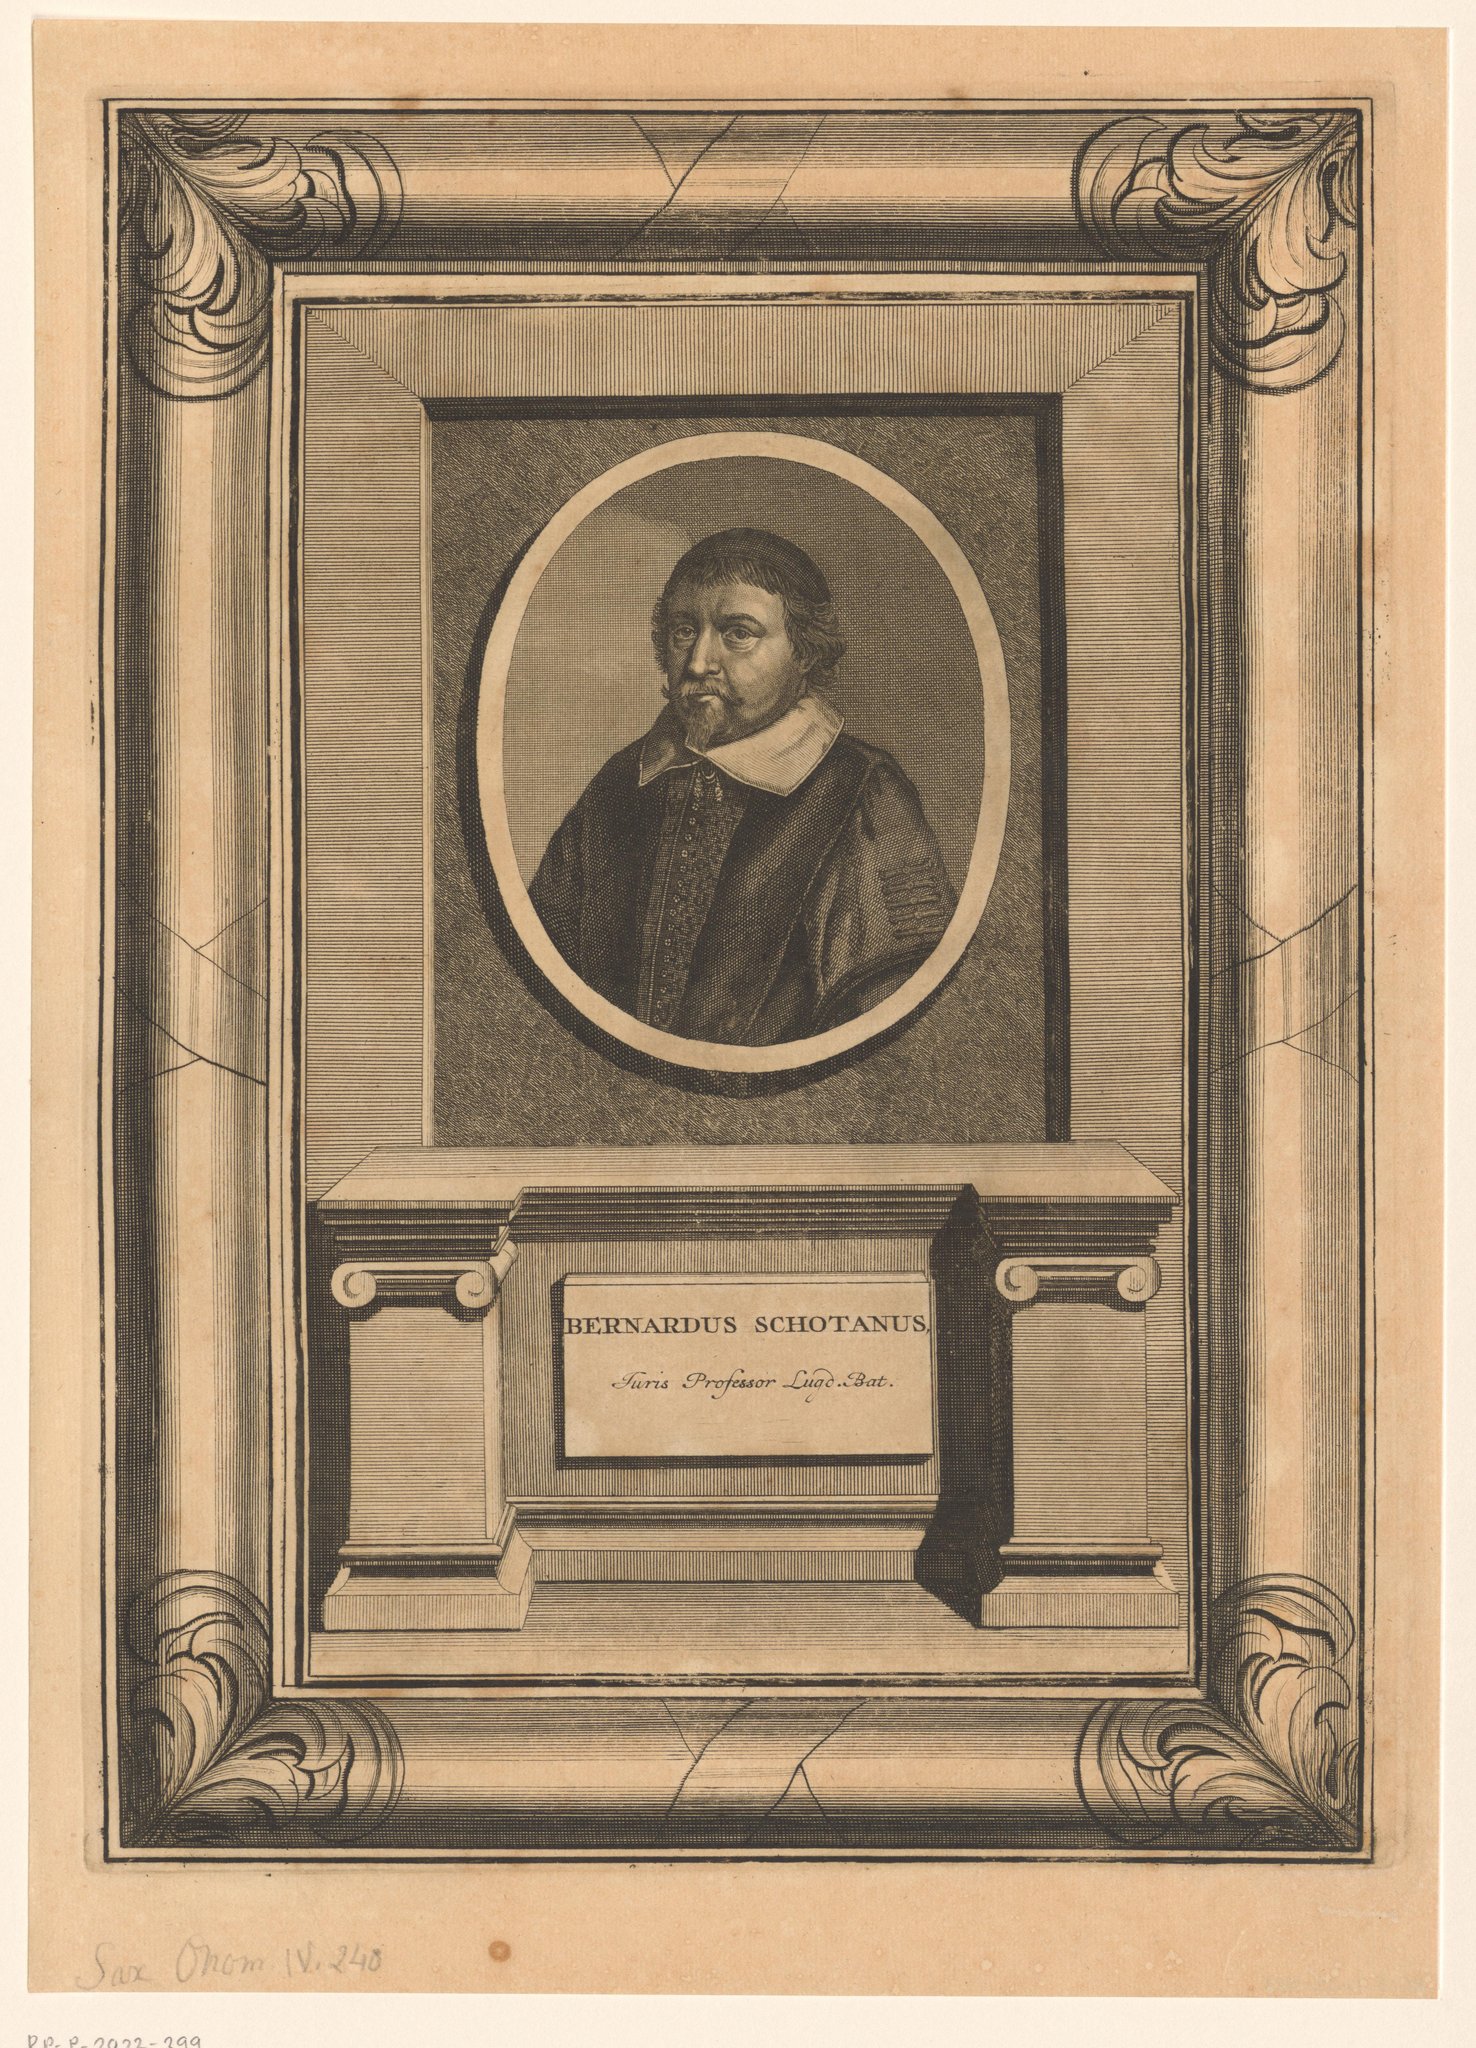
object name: print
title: Portret van Bernardus Schotanus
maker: Anonymous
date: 1720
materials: paper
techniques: engraving, etching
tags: bernardus schotanus, historical persons, professor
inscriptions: inscription: ‘Sax Orom IV.240’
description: Prent zonder omlijsting gebruikt in: Fundatoris, curatorum et professorum celeberrimorum, aliorumque illustrium virorum (...). Leiden: Pieter van der Aa, [1720].